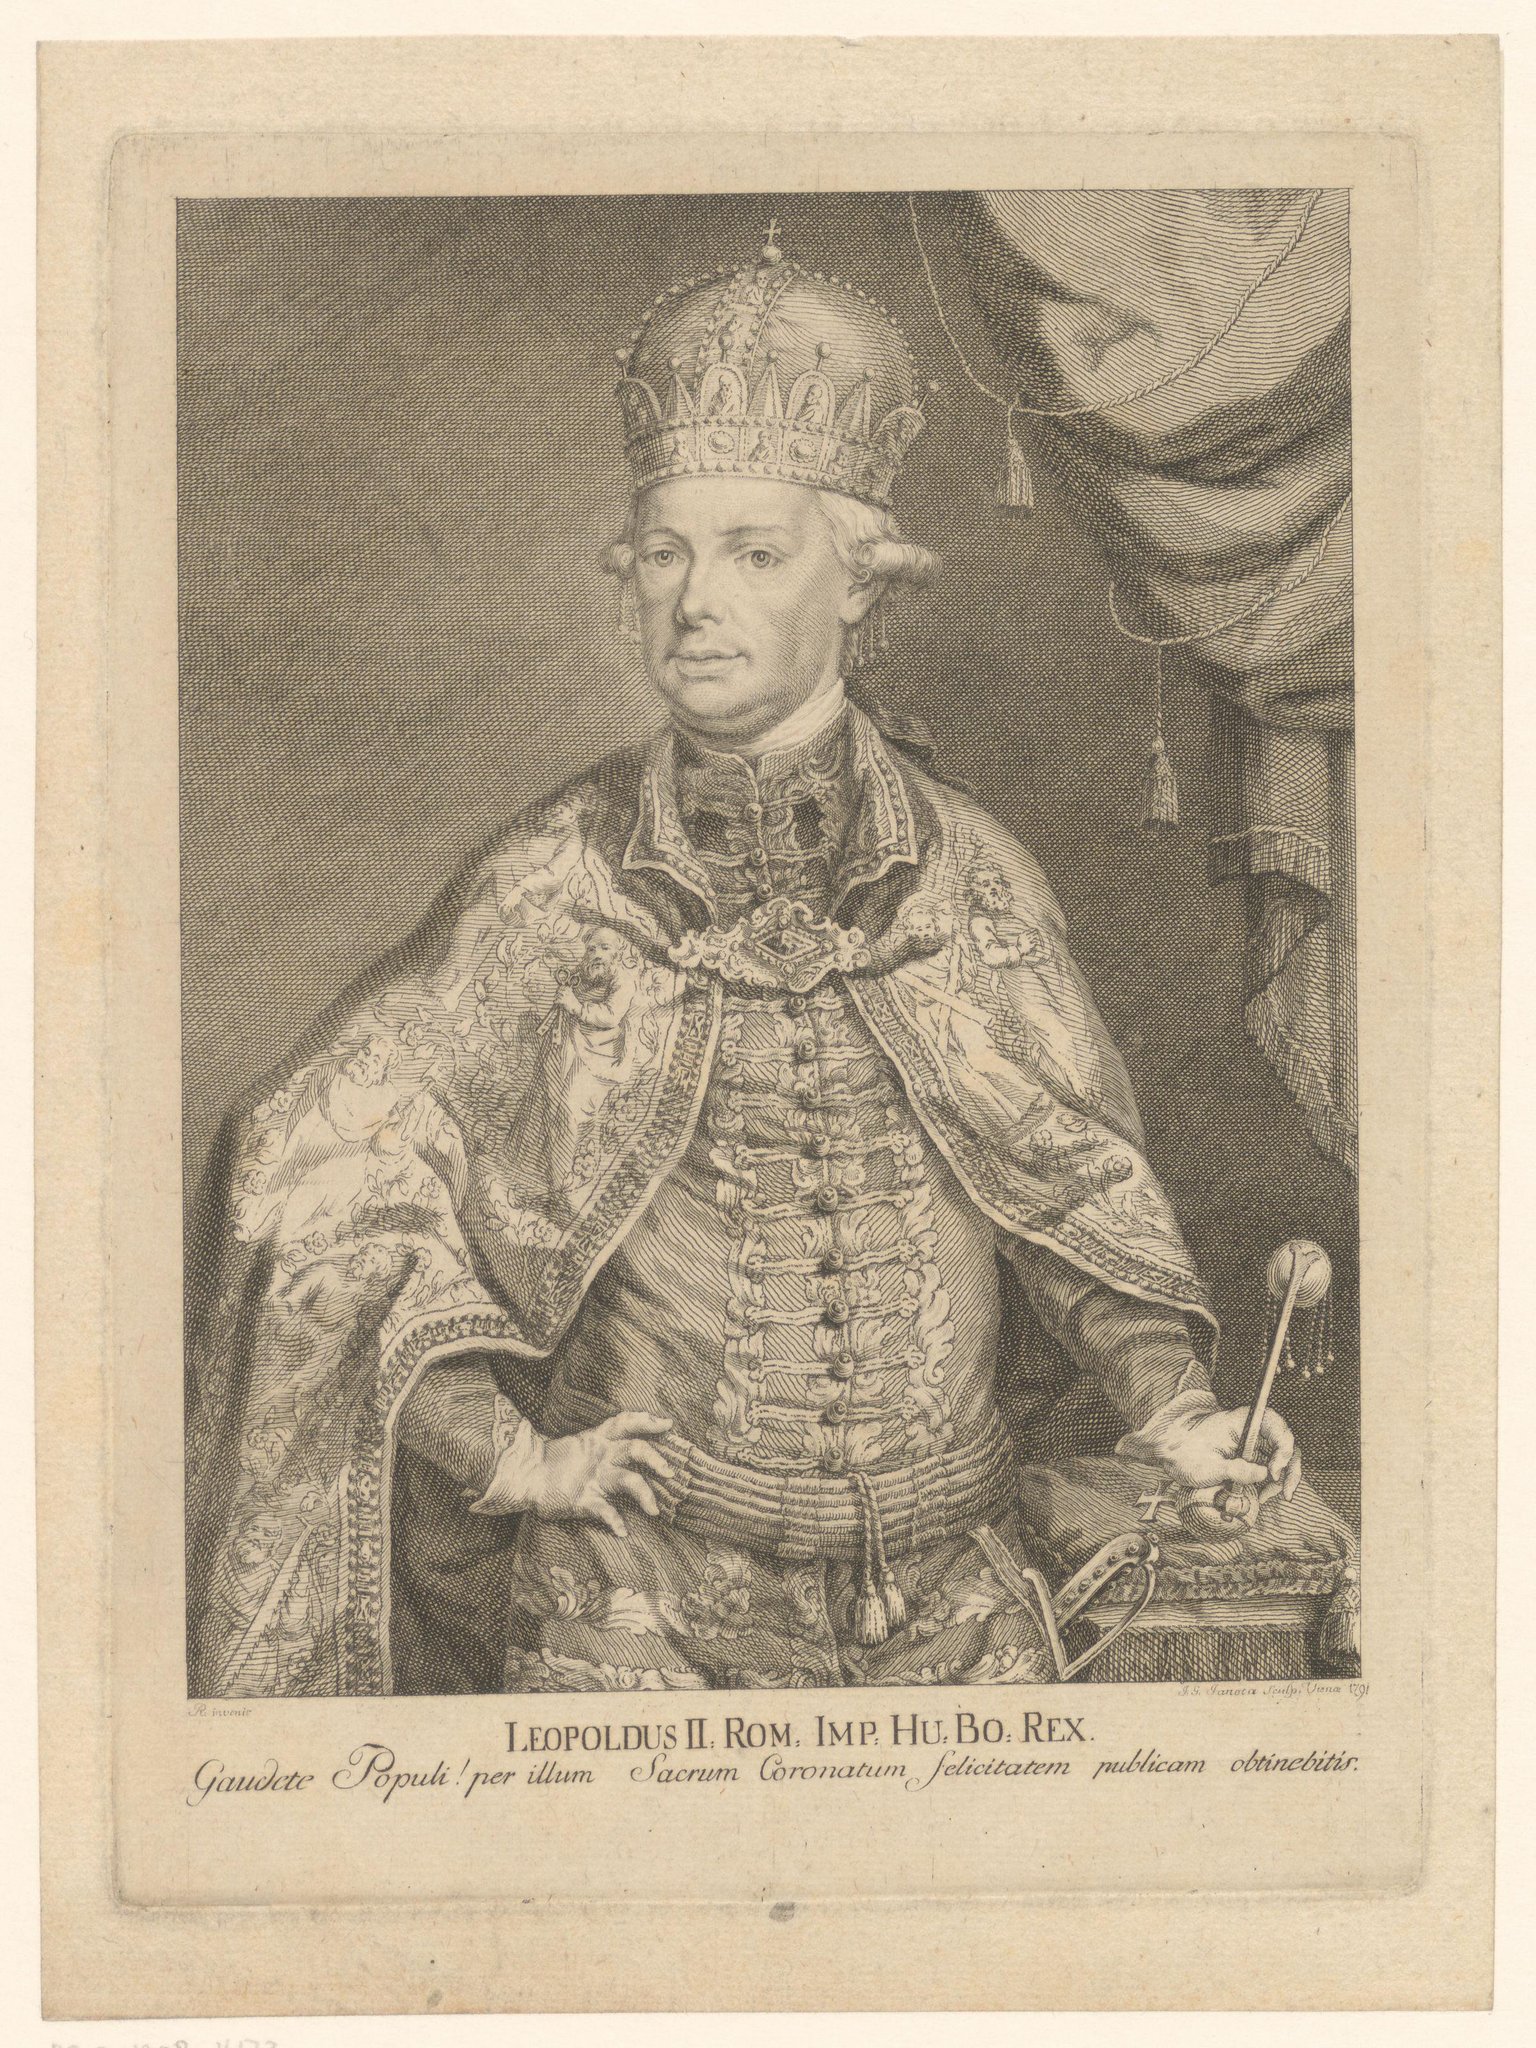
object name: print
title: Portret van Leopold II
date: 1791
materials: paper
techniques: engraving, etching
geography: vienna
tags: vienna, leopold ii (keizer van oostenrijk), historical persons, pope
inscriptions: collector's mark: Lugt 2228